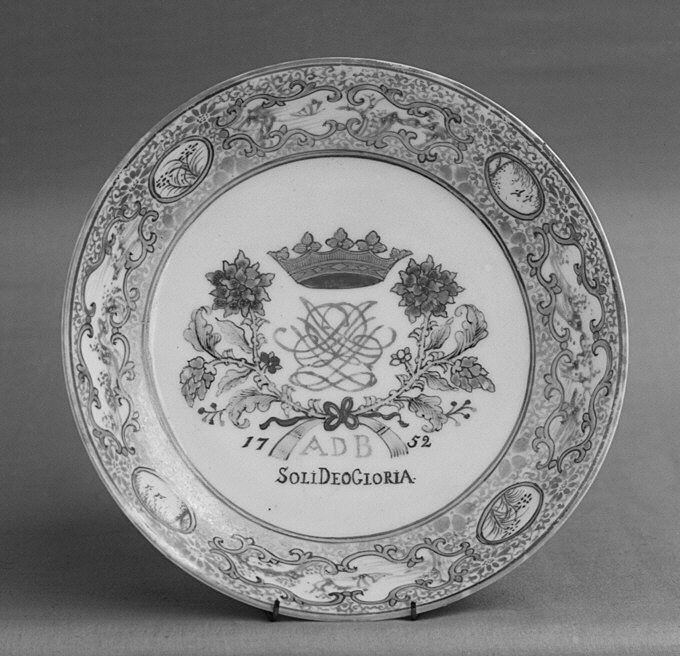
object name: saucer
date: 1752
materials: hard paste porcelain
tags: flowers,coat of arms